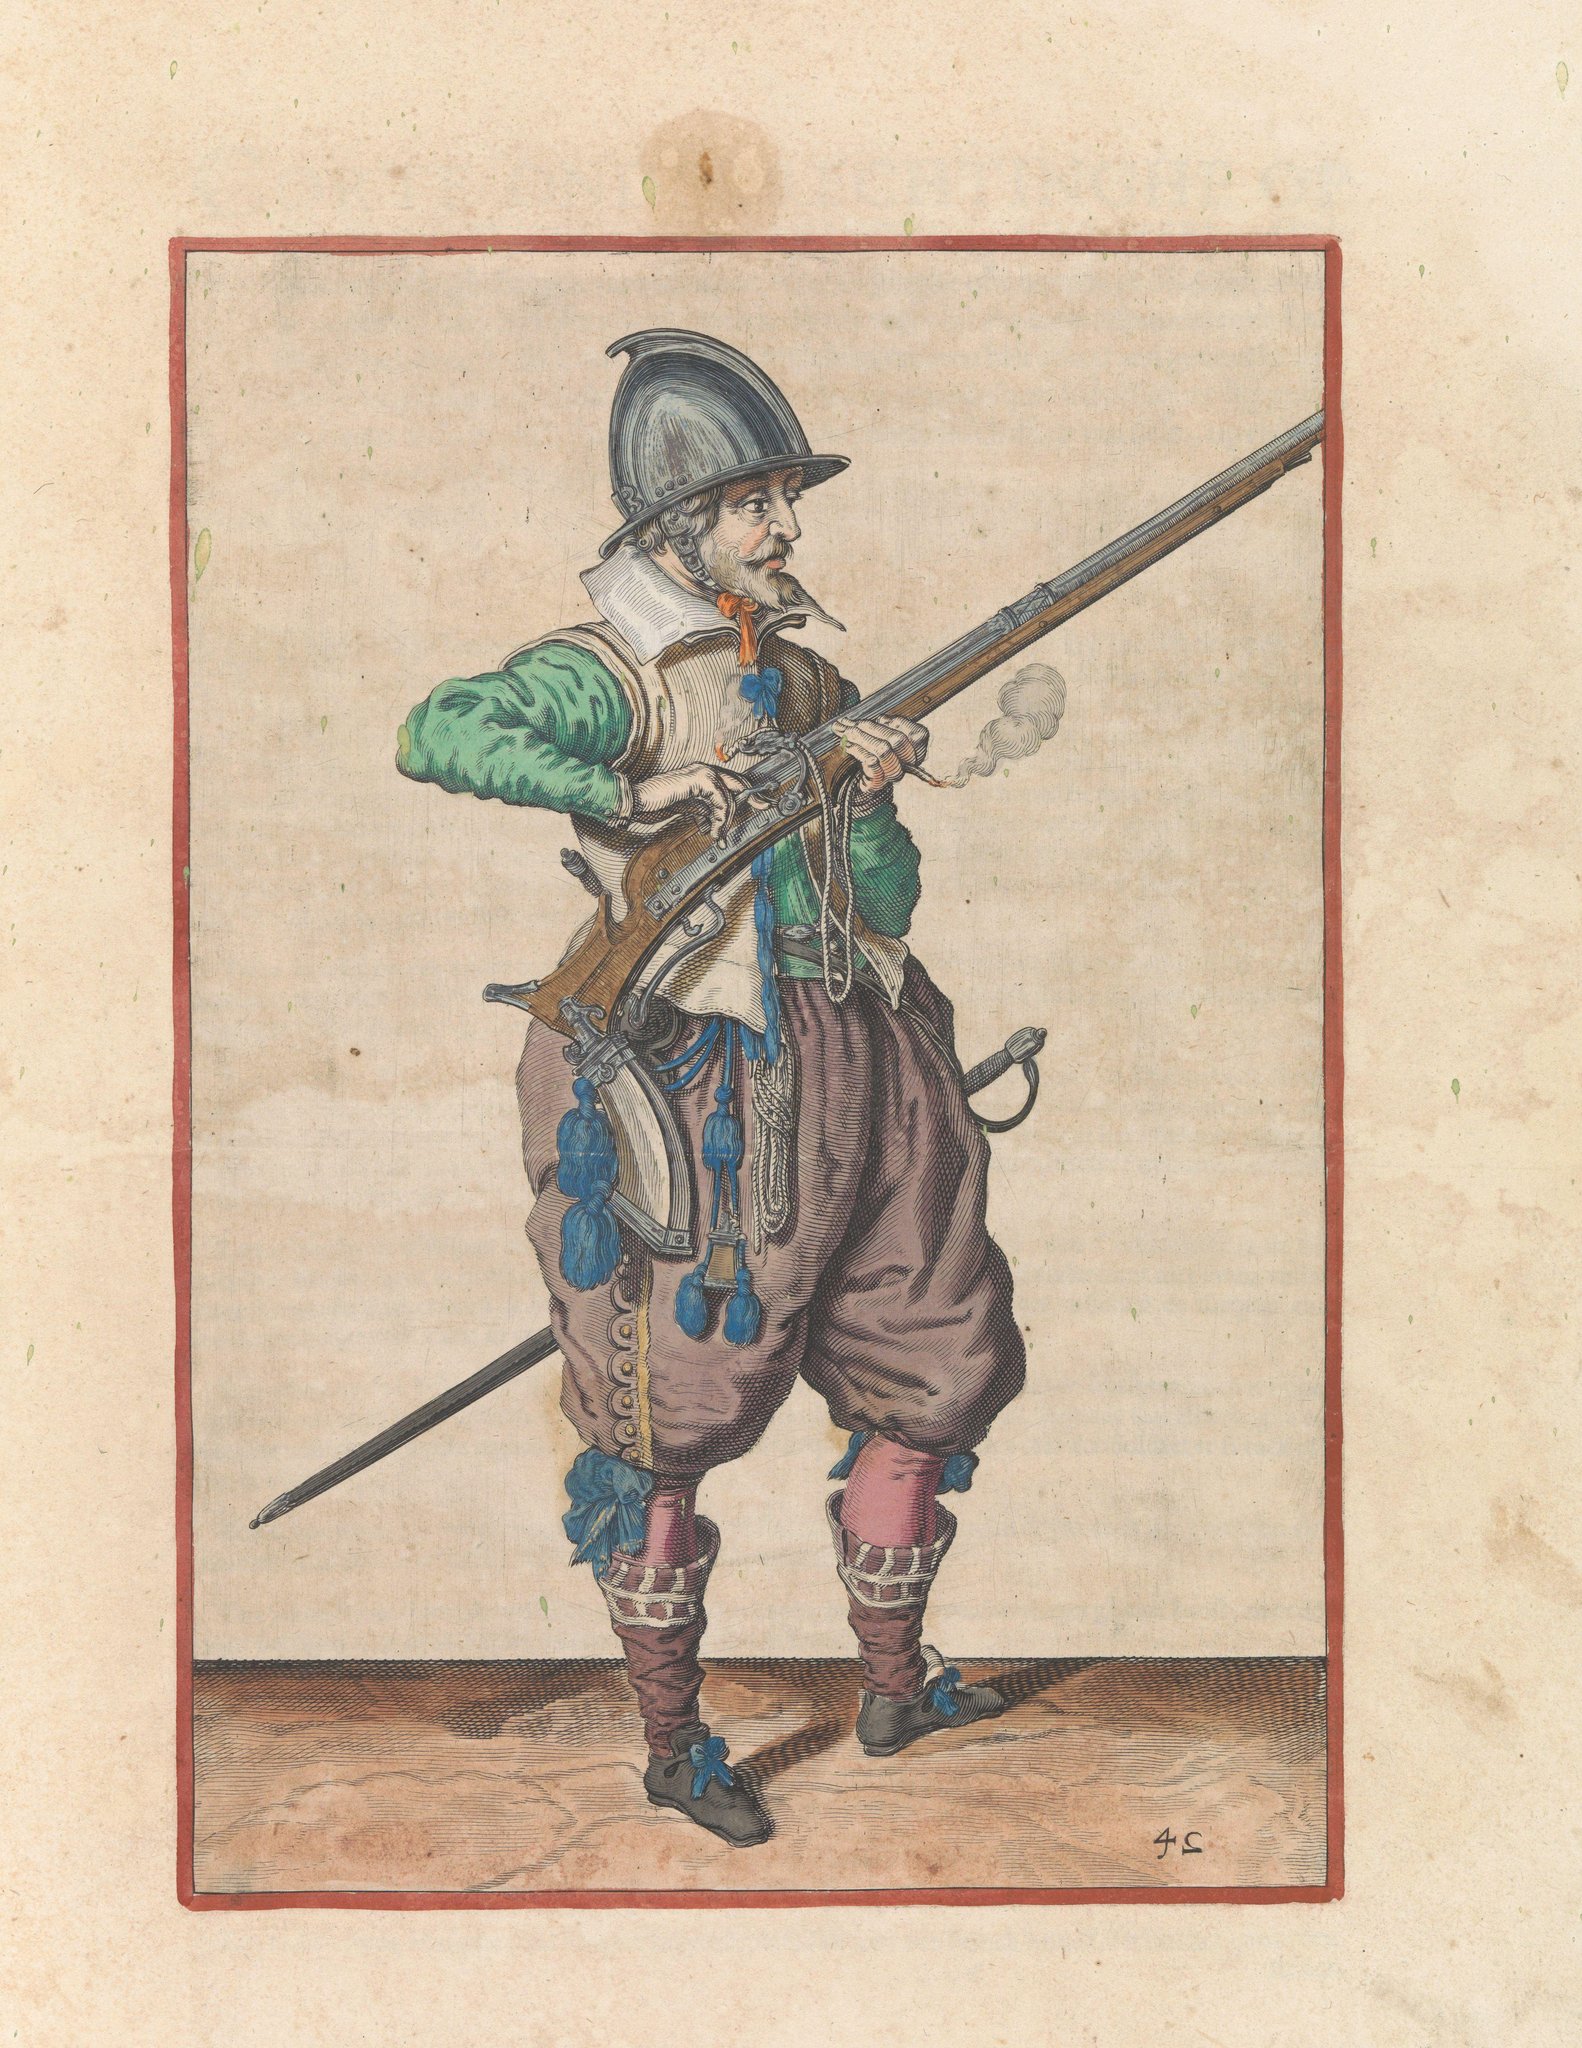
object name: print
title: Soldaat op wacht die de pan van zijn roer met twee vingers bedekt tegen vonken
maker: jacques de gheyn (ii)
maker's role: painter, print maker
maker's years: 1565-1629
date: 1597-1607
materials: paper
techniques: engraving, hand coloring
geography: the hague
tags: handling of weapons ~ military training, firearms: rifle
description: Een soldaat op wacht, ten voeten uit, naar rechts, die een roer (een bepaald type vuurwapen) met zijn linkerhand vasthoudt. Op de haan (onderdeel van het ontstekingsmechanisme) van zijn roer ligt de brandende lont. Met de wijsvinger en de middelvinger van zijn rechterhand bedekt hij de pan (het kruitreservoir) van zijn roer om het kruit te beschermen tegen vonken van de lont. Deze prent is onderdeel van de reeks van 42 met de hand genummerde prenten van roerschutters in de Wapenhandelinghe. Op dit is exemplaar het nummer gedrukt.